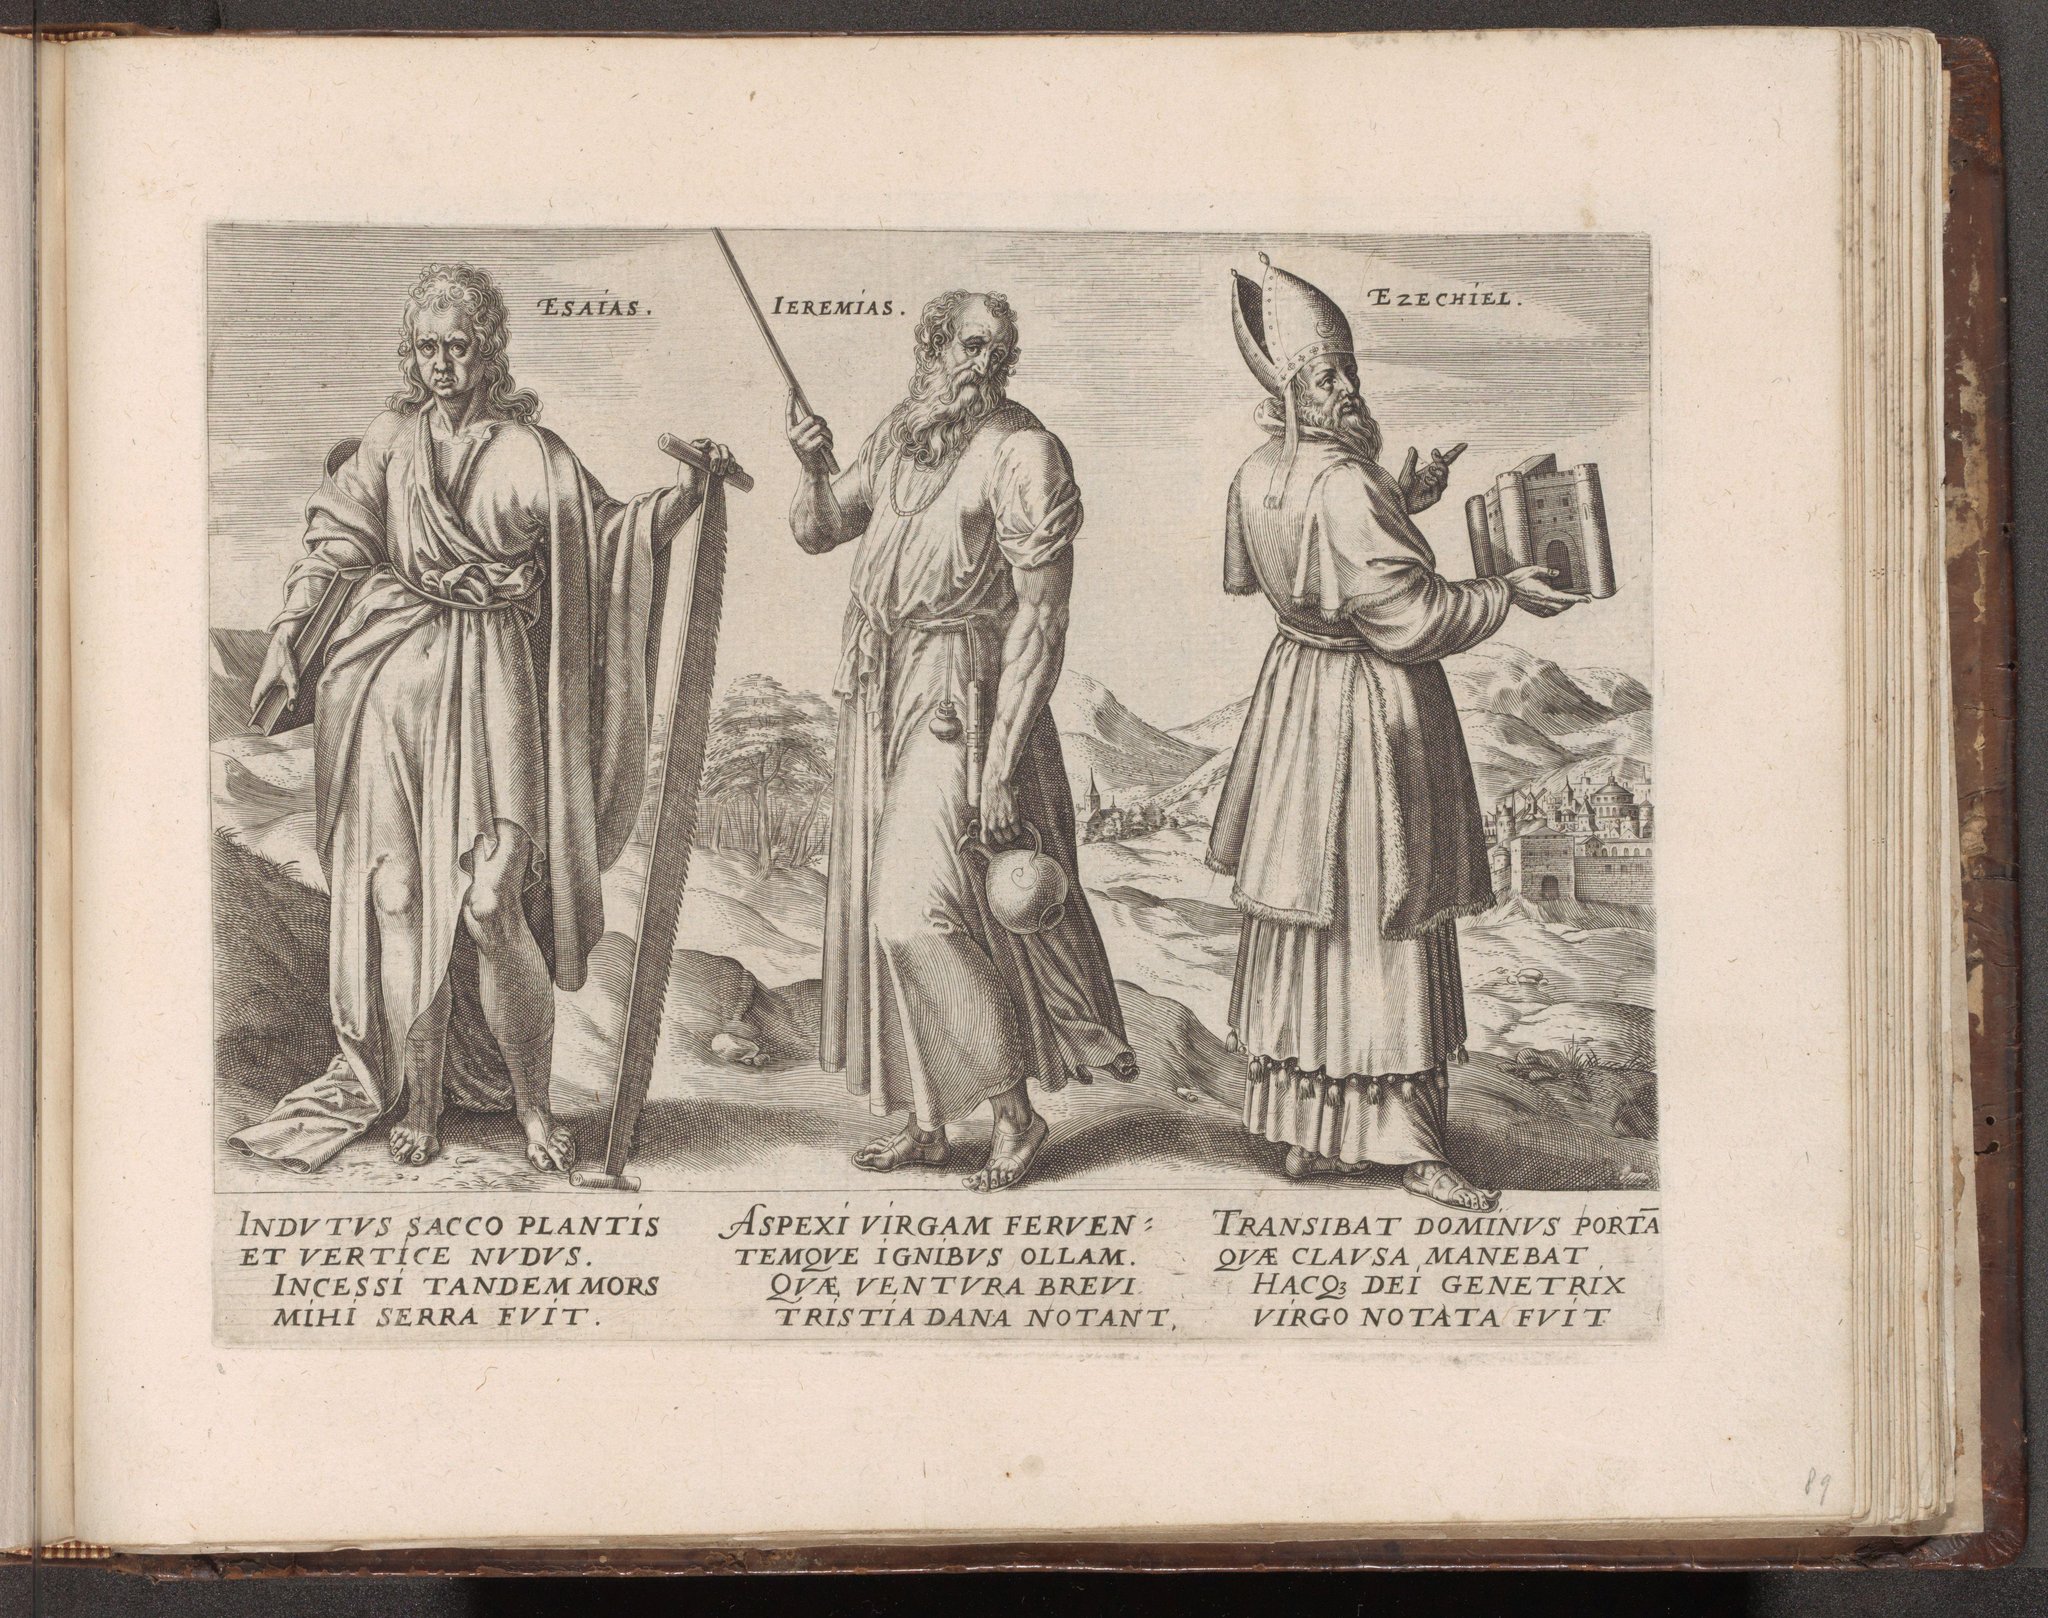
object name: album leaf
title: Jesaja, Jeremia en Ezechiël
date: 1579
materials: paper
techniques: engraving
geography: antwerp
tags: the four major prophets (not in biblical context): isaiah, jeremiah, ezekiel, daniel, jeremiah (not in biblical context); possible attributes: book or scroll, 'the seething pot', isaiah (not in biblical context); possible attributes: branch with leaves, saw, scroll or book, ezekiel (not in biblical context); possible attributes: book or scroll, double wheel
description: De profeten Jesaja, Jeremia en Ezechiël staan naast elkaar in een landschap. Jesaja houdt een boek onder de arm en houdt een zaag in zijn hand, Jeremia houdt een staf en kruik in de handen, Ezechiël houdt de tempel in zijn hand, die hij in een visioen zag. Onder de voorstelling toelichtingen in het Latijn. Prent maakt deel uit van een album.